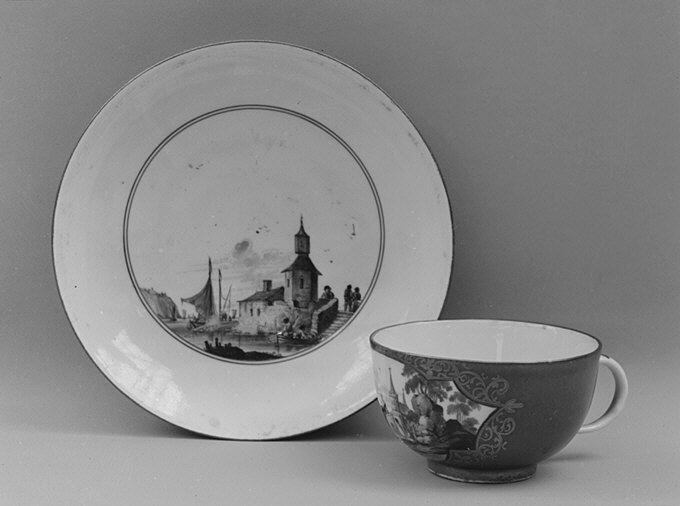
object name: cup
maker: meissen manufactory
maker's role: manufactory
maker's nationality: german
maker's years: 1710-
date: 1740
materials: hard paste porcelain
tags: buildings,trees